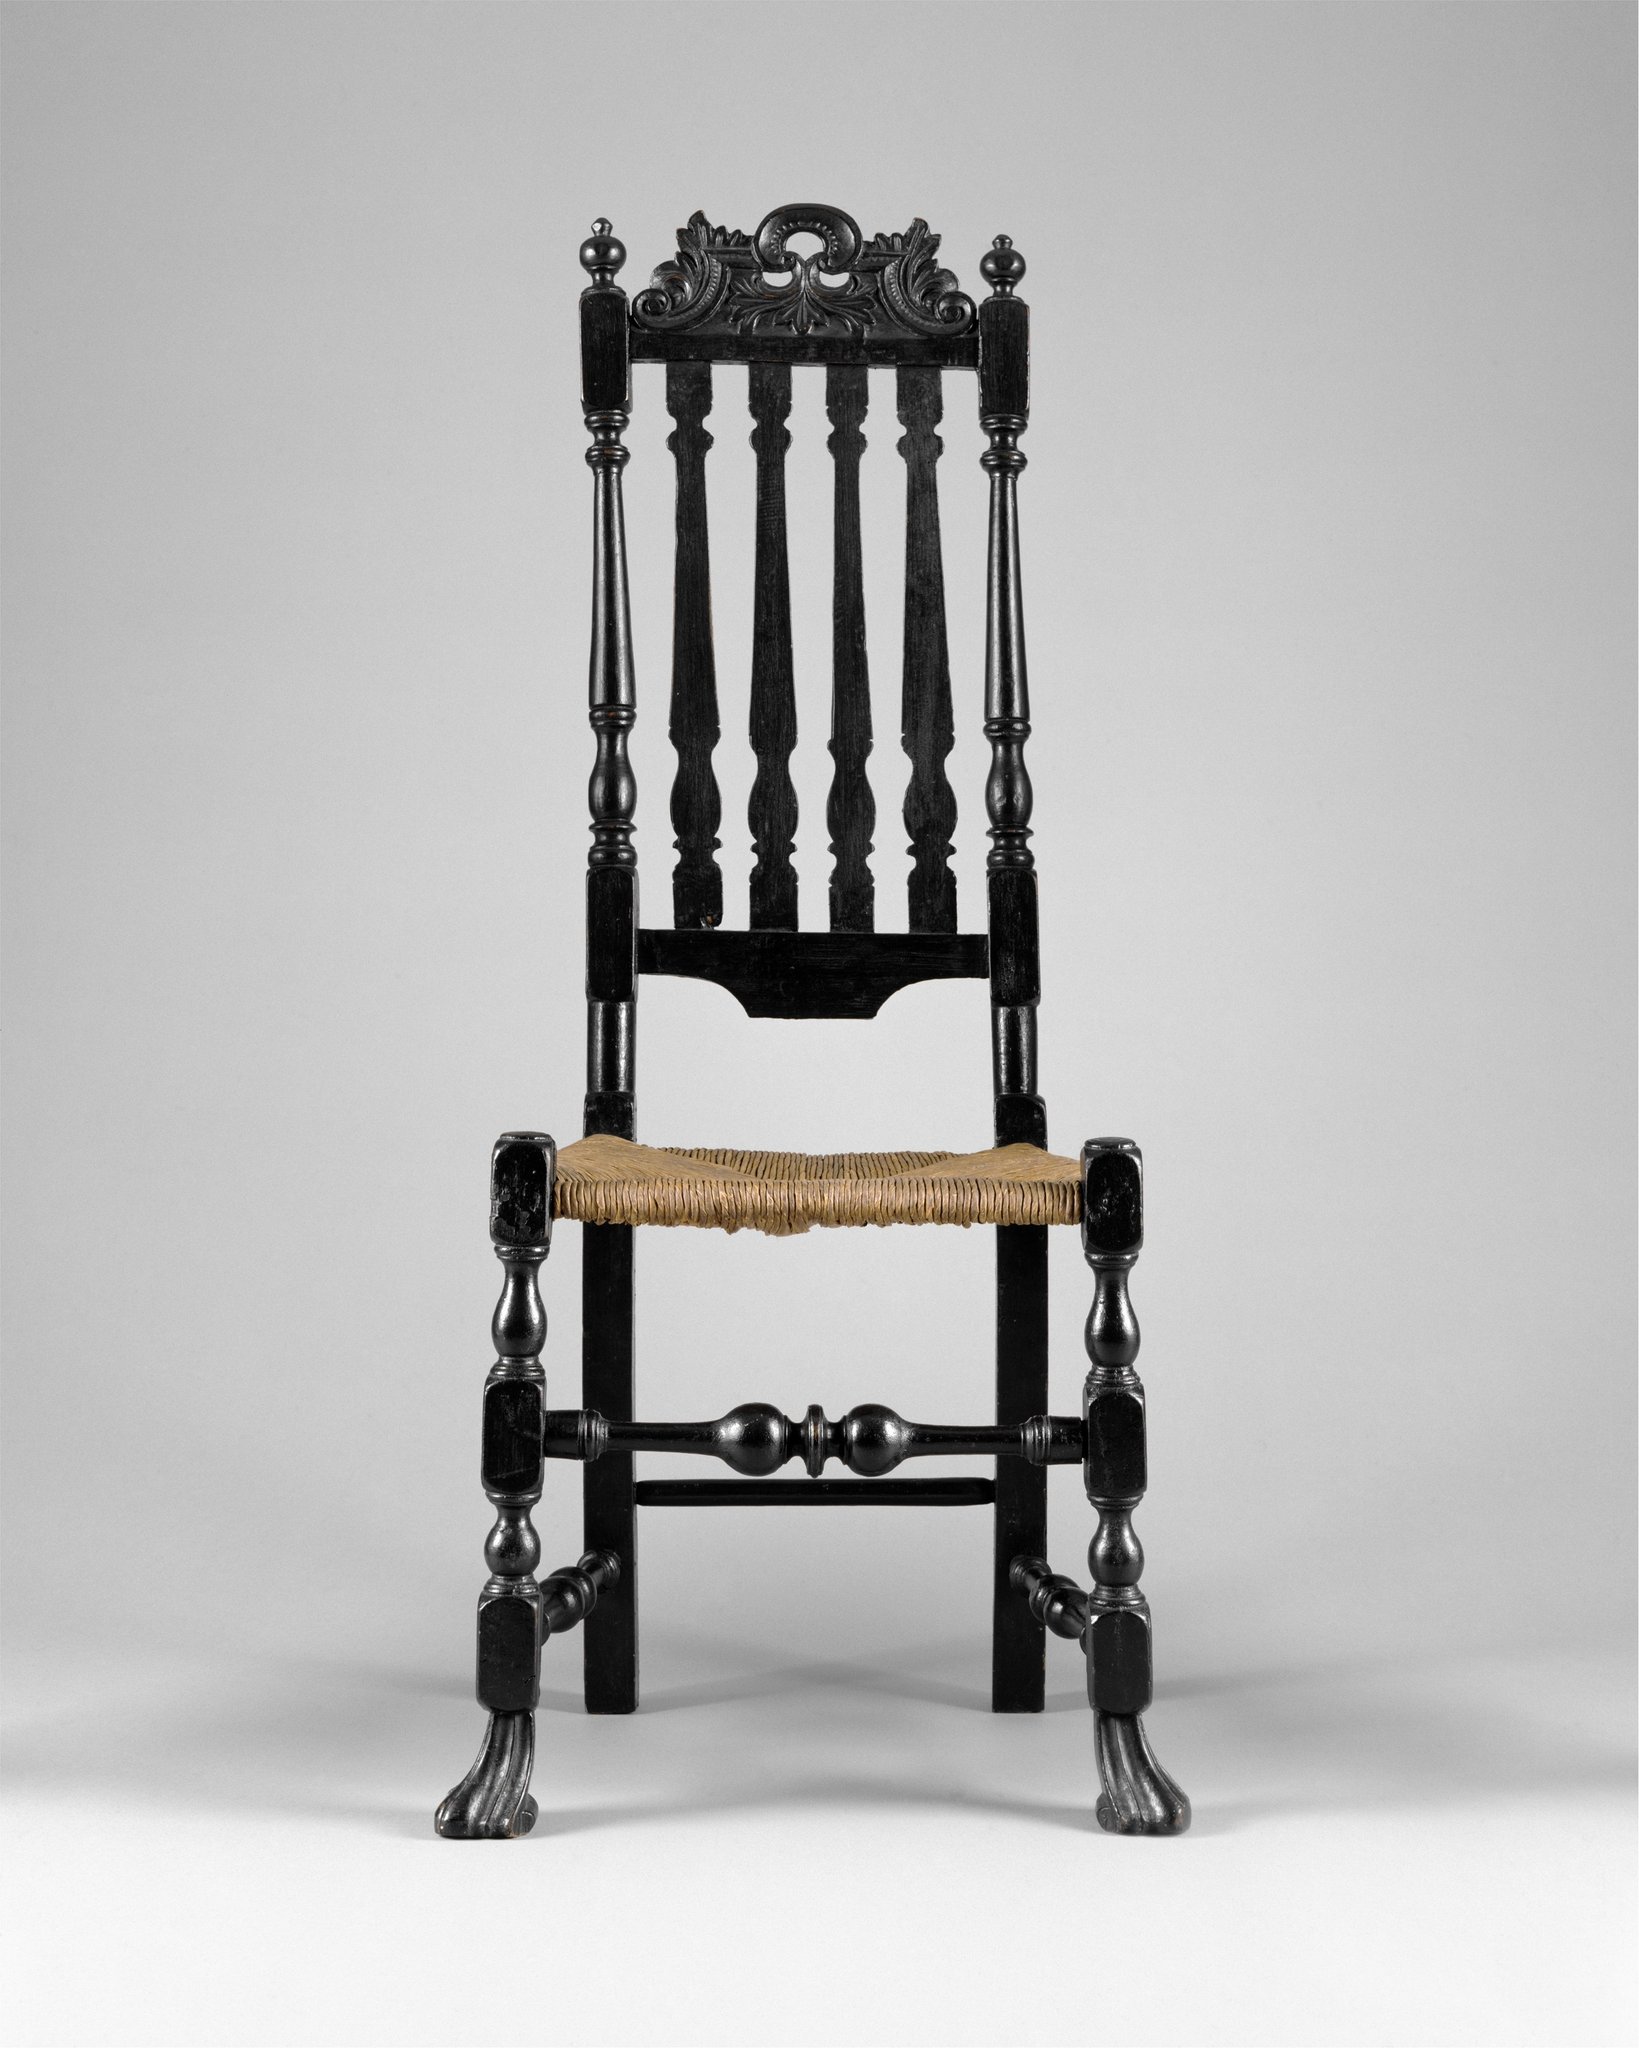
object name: side chair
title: Banister-back chair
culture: american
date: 1715-1735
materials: wood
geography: united states